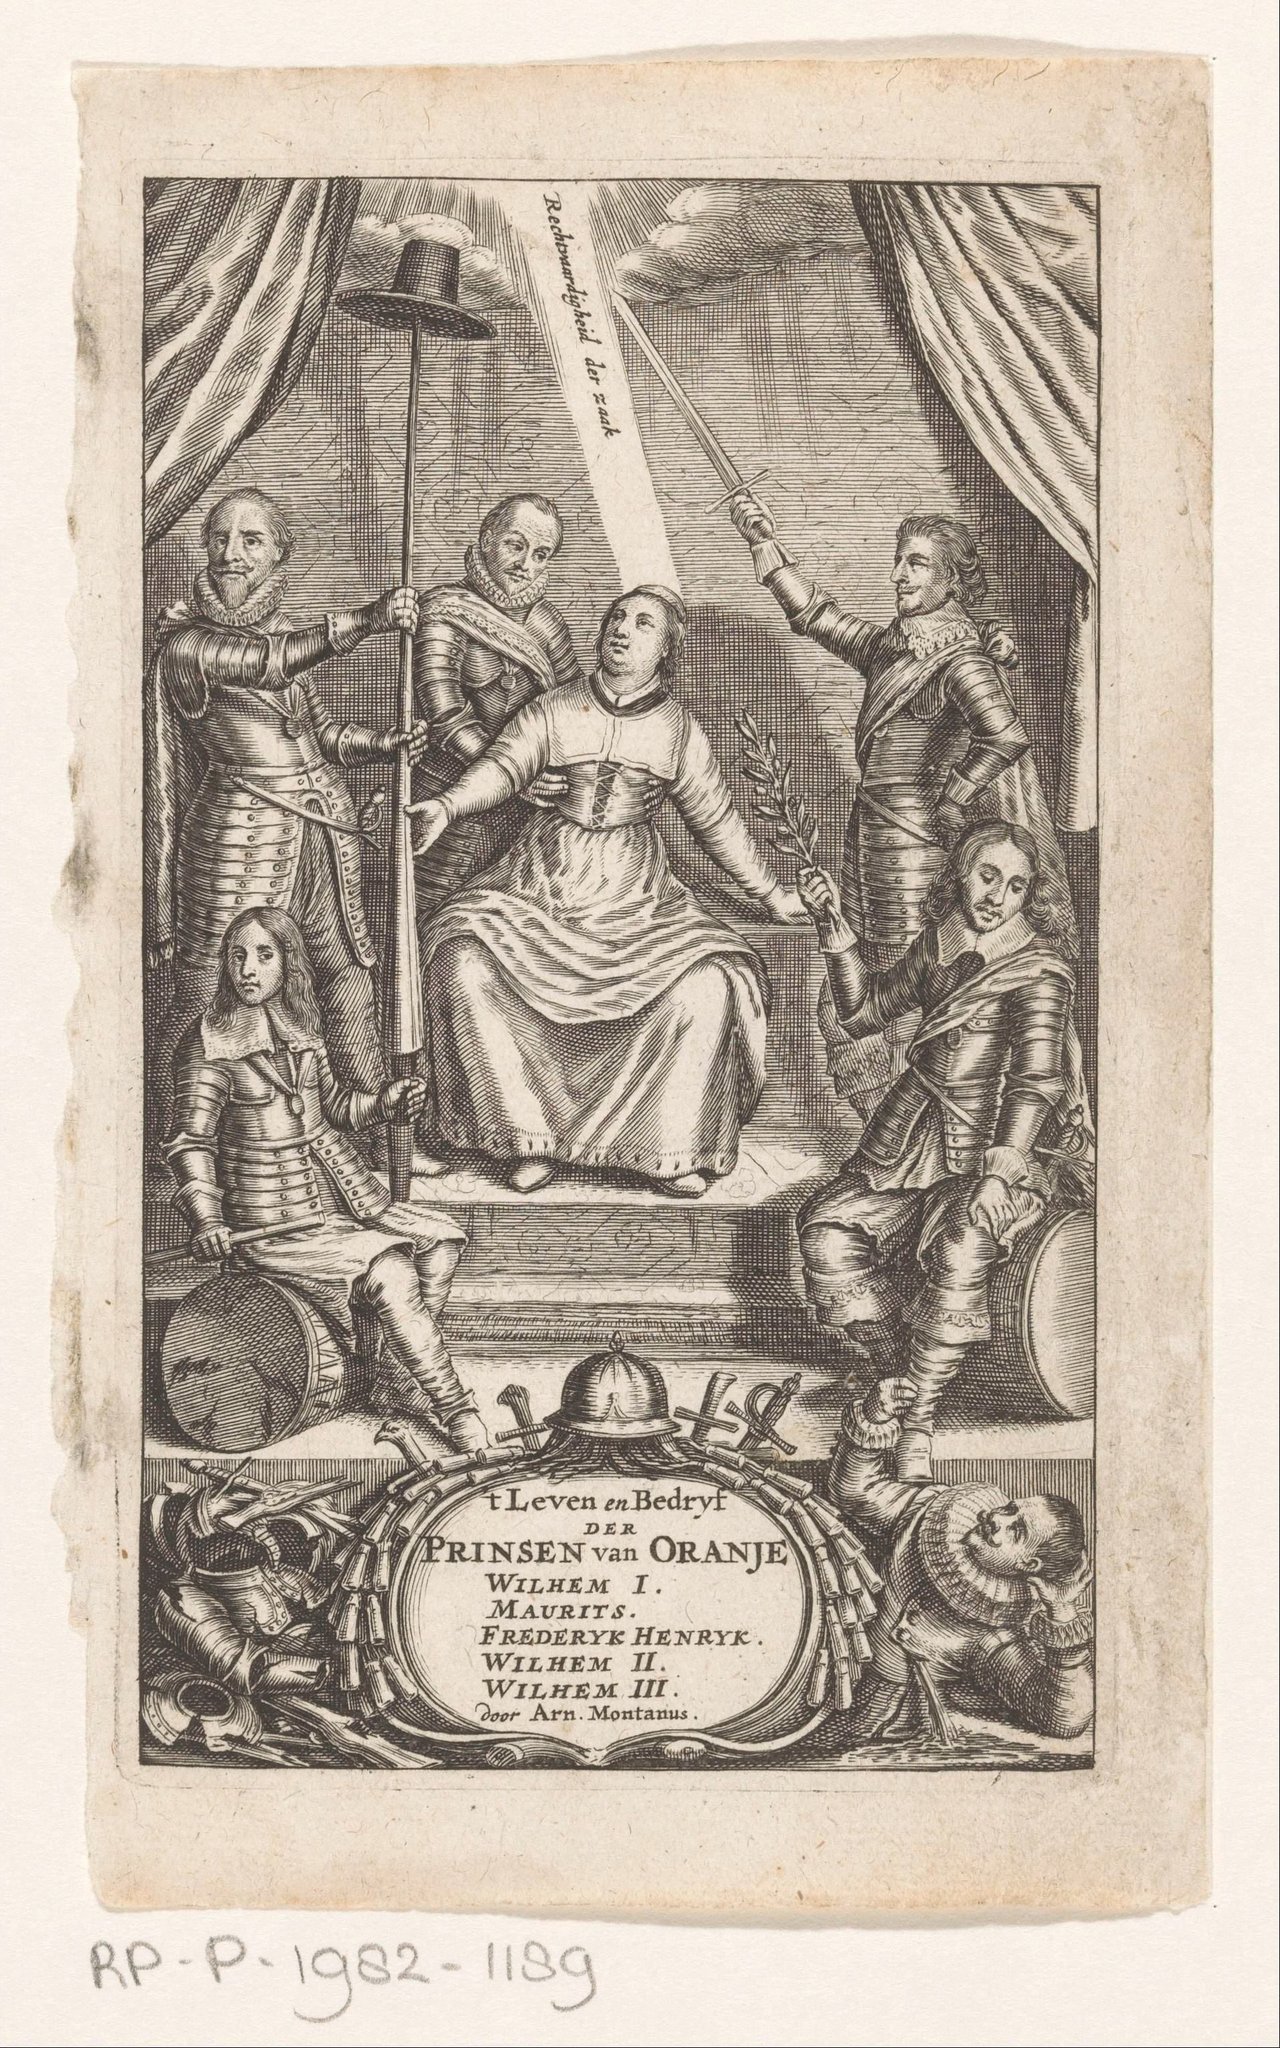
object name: print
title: Hollandse Maagd en vijf prinsen van Oranje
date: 1664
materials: paper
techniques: engraving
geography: amsterdam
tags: william iii (prince of orange and king of england, scotland, and ireland), frederick henry (prince of orange), william ii (prince of orange), william i (prince of orange), the hague, maurice (prince of orange), personifications of countries, nations, states, districts, etc., prince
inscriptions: collector's mark: Lugt 2228, collector's mark: Lugt 2760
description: Prinsen van Oranje Willem I, Maurits, Frederik Hendrik, Willem II en Willem III staan en zitten met vrijheidshoed, zwaard en lauwertak rondom de Hollandse Maagd. Vanuit de hemel een lichtstraal met de tekst Rechtvaardigheid der zaak.